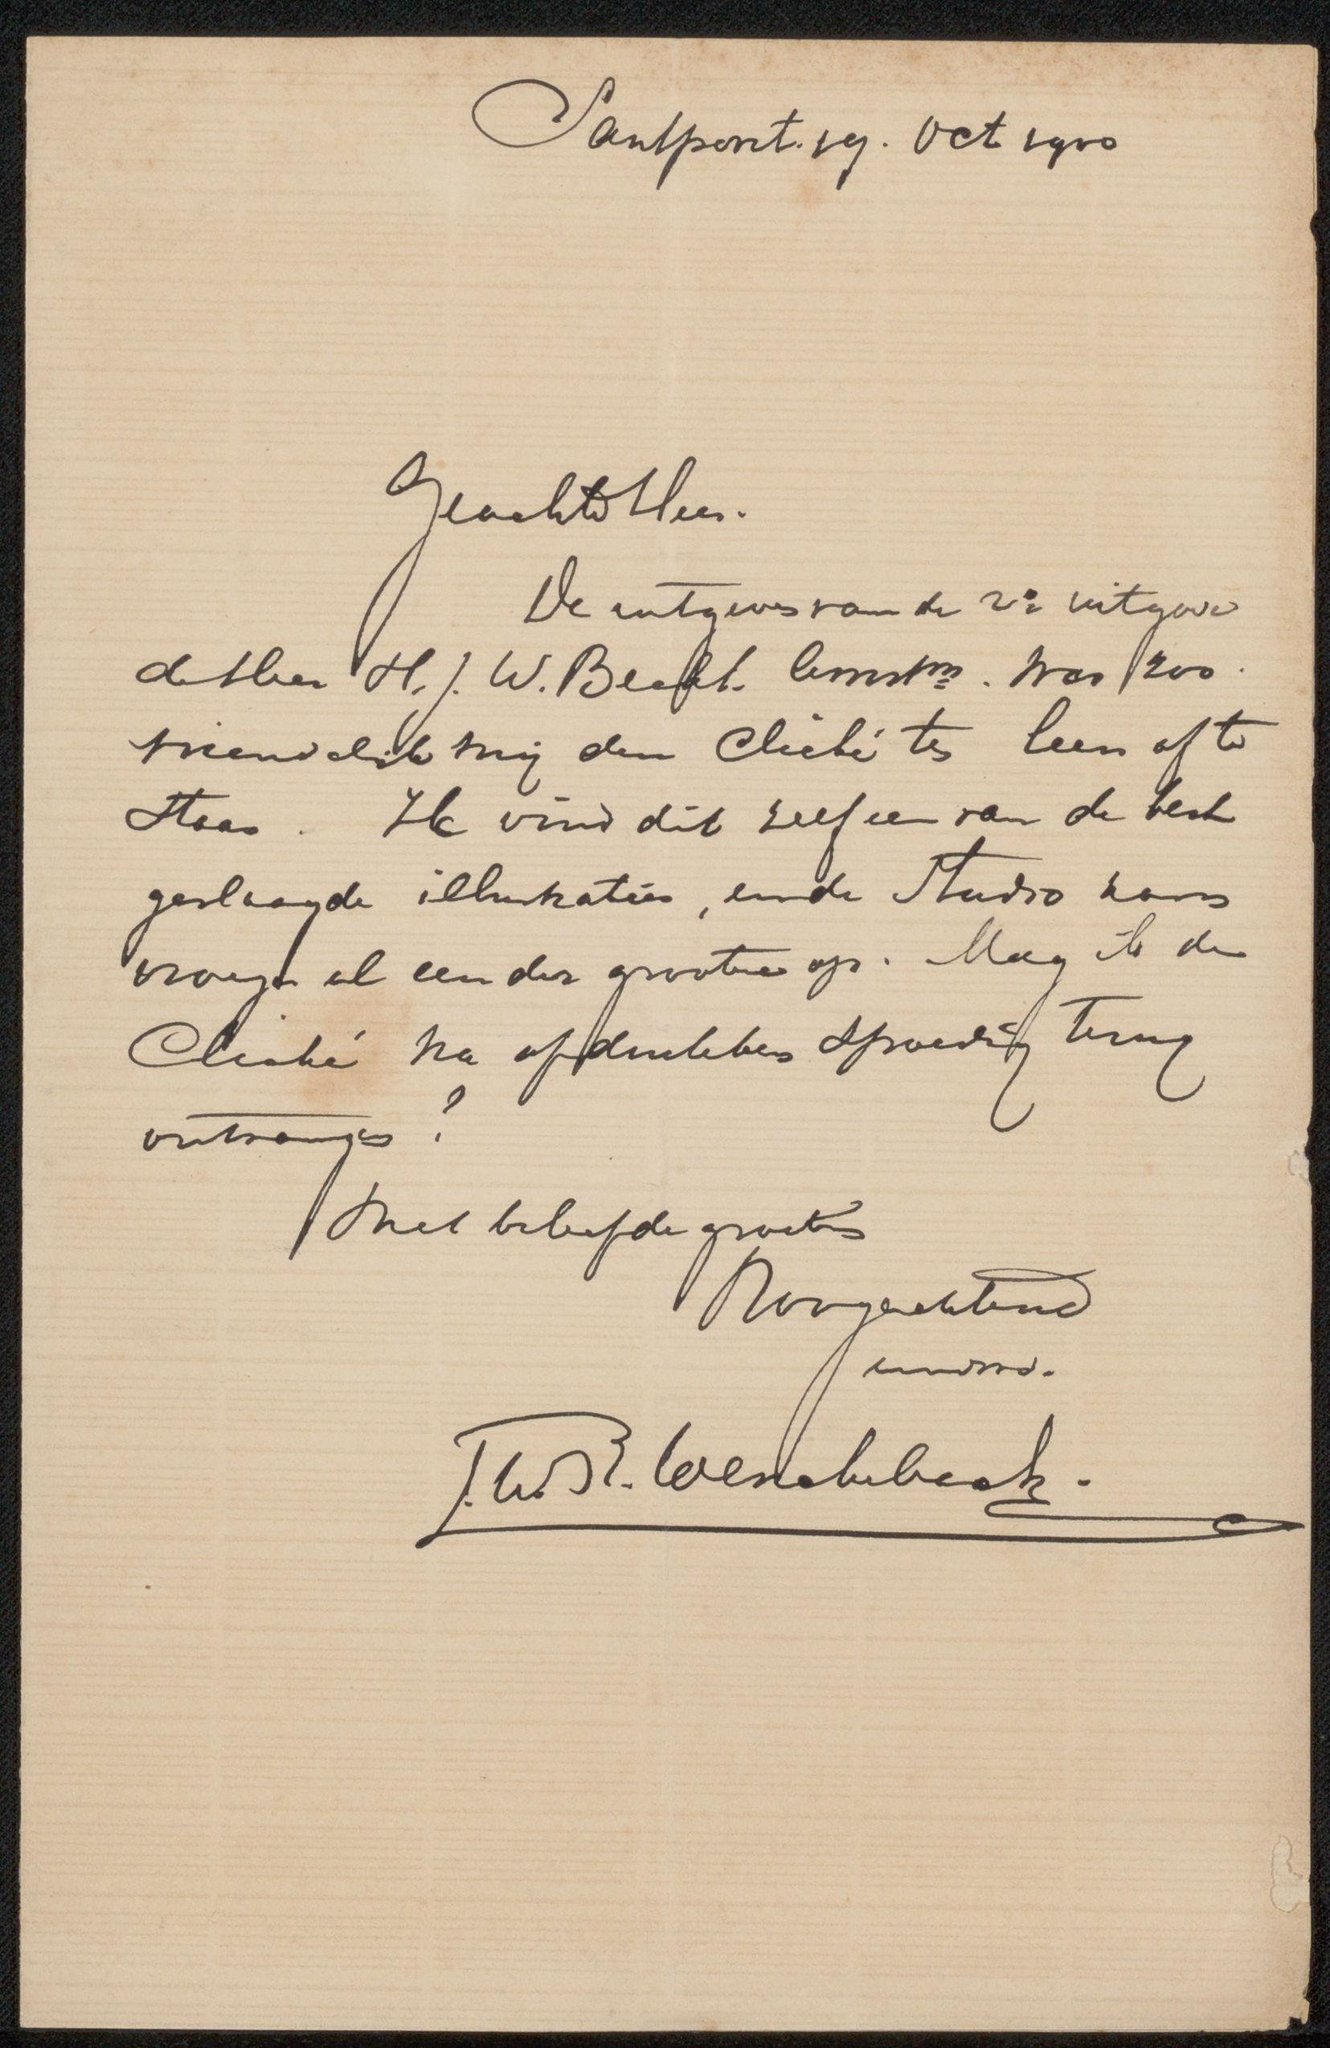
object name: letter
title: Brief aan Philip Zilcken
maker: willem wenckebach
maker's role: designer, draughtsman, painter, print maker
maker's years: 1860-1937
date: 1900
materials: ink, paper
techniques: pen, writing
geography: santpoort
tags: amsterdam, publisher, herman johan wilhelm becht, the hague, painter, draughtsman, philip zilcken, illustration ~ printed matter, book, printed matter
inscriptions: collector's mark: ‘RPK’